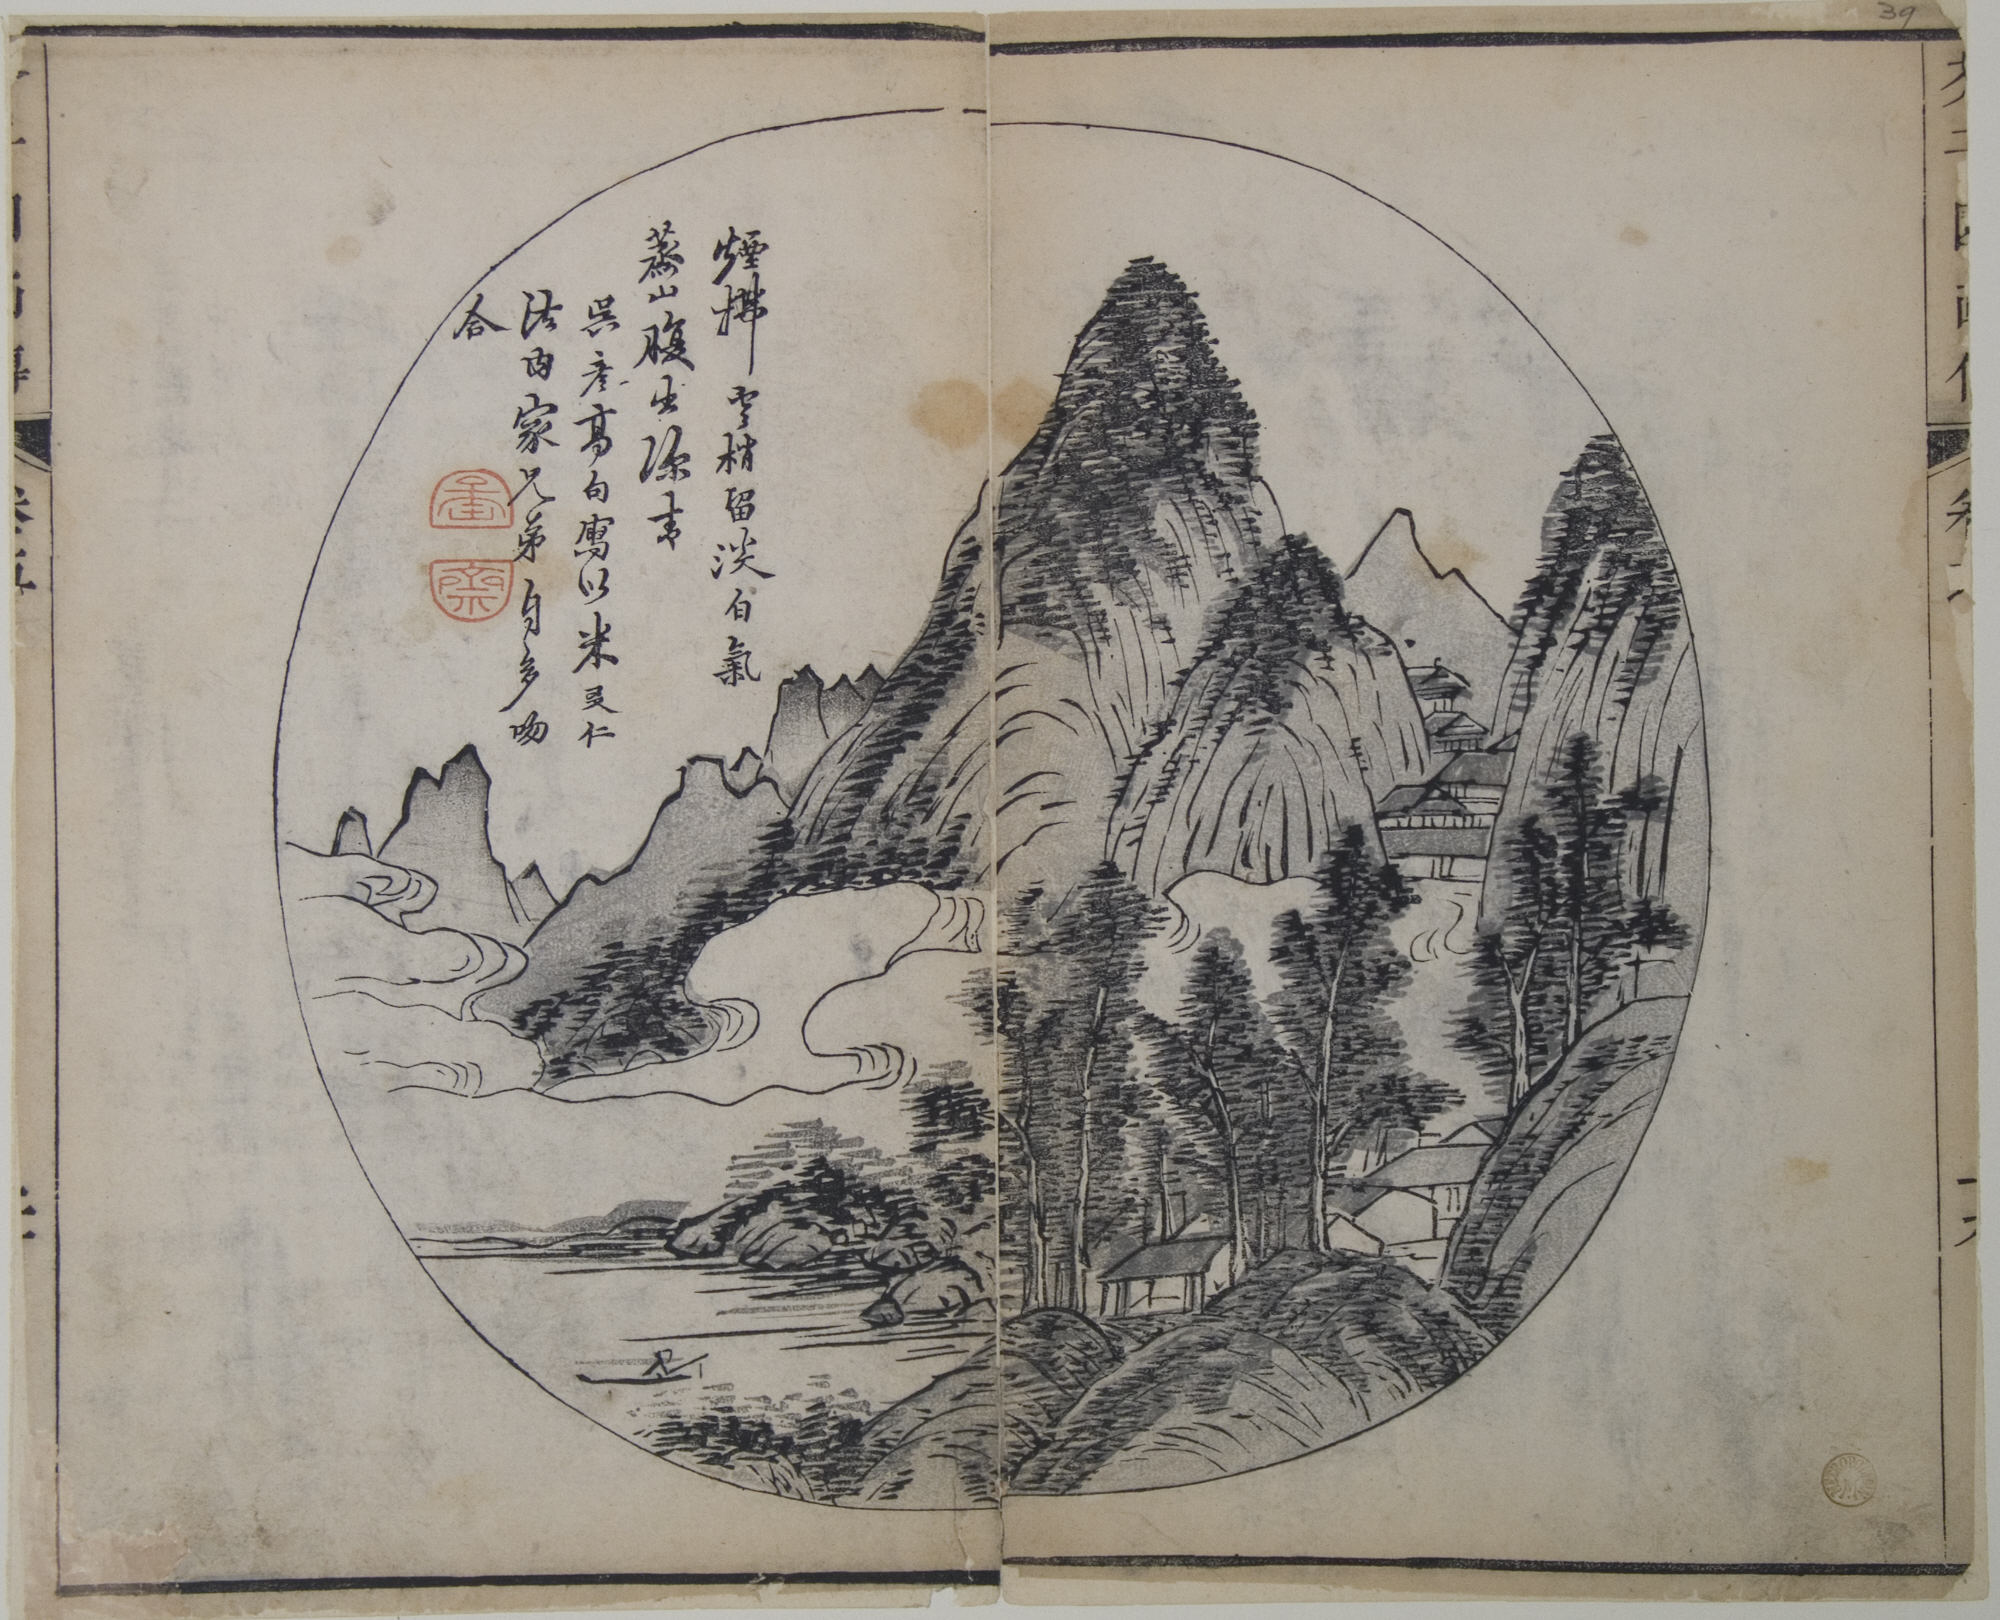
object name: print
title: Page from the Mustard Seed Garden Manual of Painting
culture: chinese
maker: wang gai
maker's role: artist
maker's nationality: chinese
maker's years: 1645-1710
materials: ink, paper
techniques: woodblock print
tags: houses,mountains